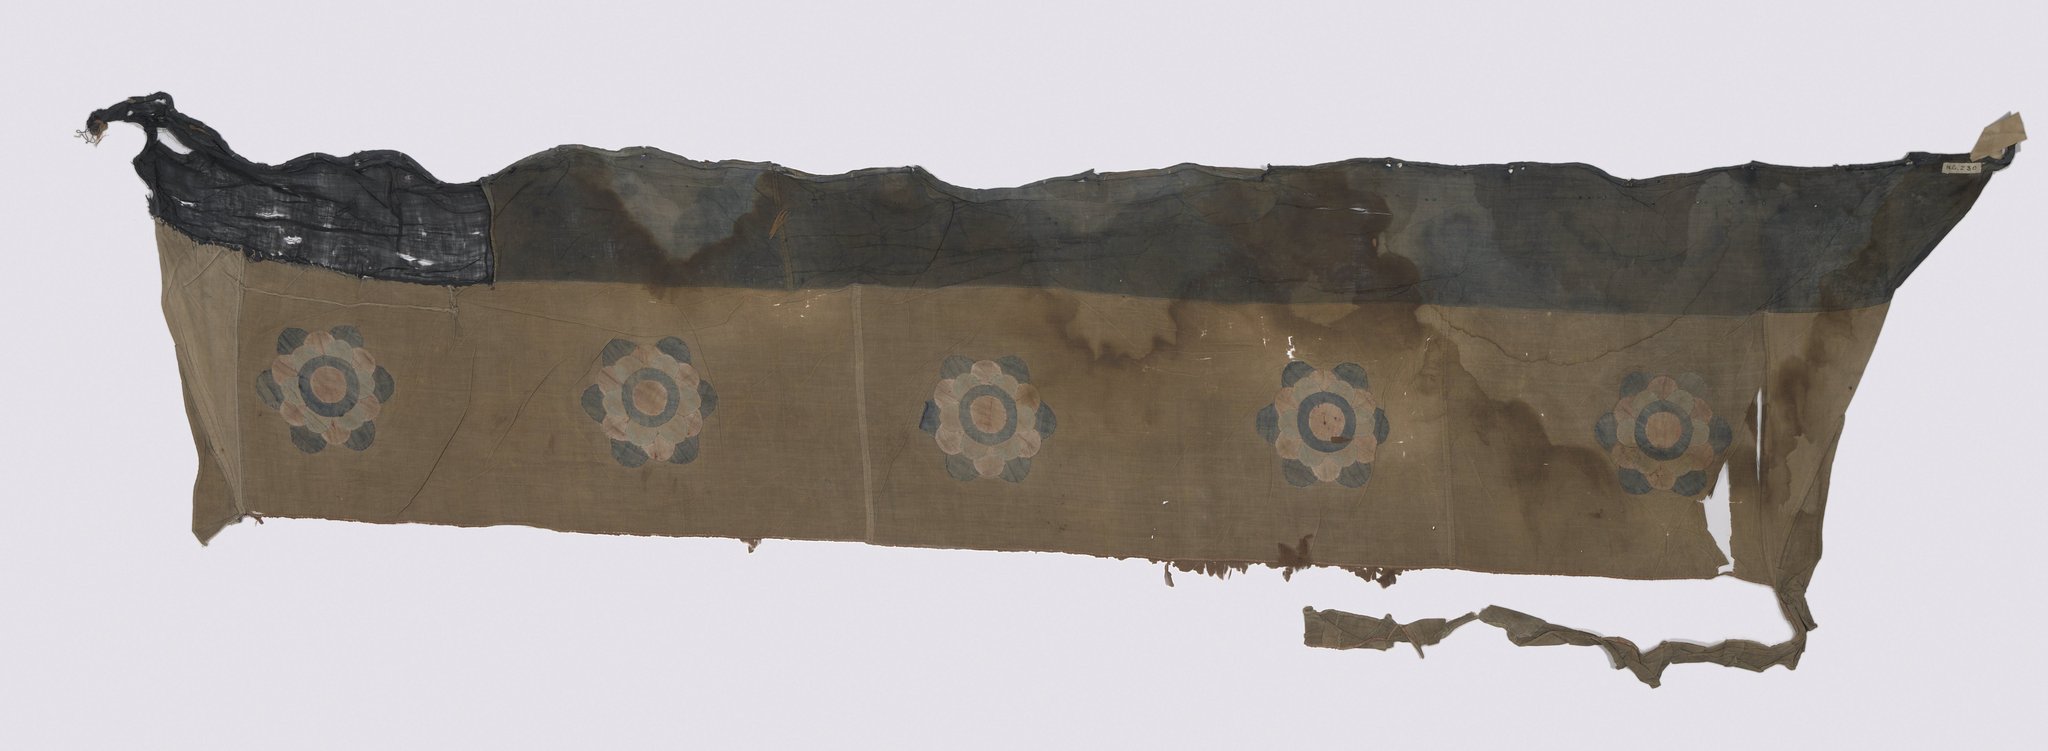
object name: flag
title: Fragment of a Flag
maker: Anonymous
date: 1750-1830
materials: cotton, linen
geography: indonesian archipelago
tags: flag, colours (as symbol of the state, etc.), dutch east indies, the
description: Fragment van een vlag. Slechts de blauwe broek met daaraan een witte verticale baan versierd met vijf rozetten is bewaard gebleven. De boven- en onderzijde zijn naar de vlucht toe afgeschuind.